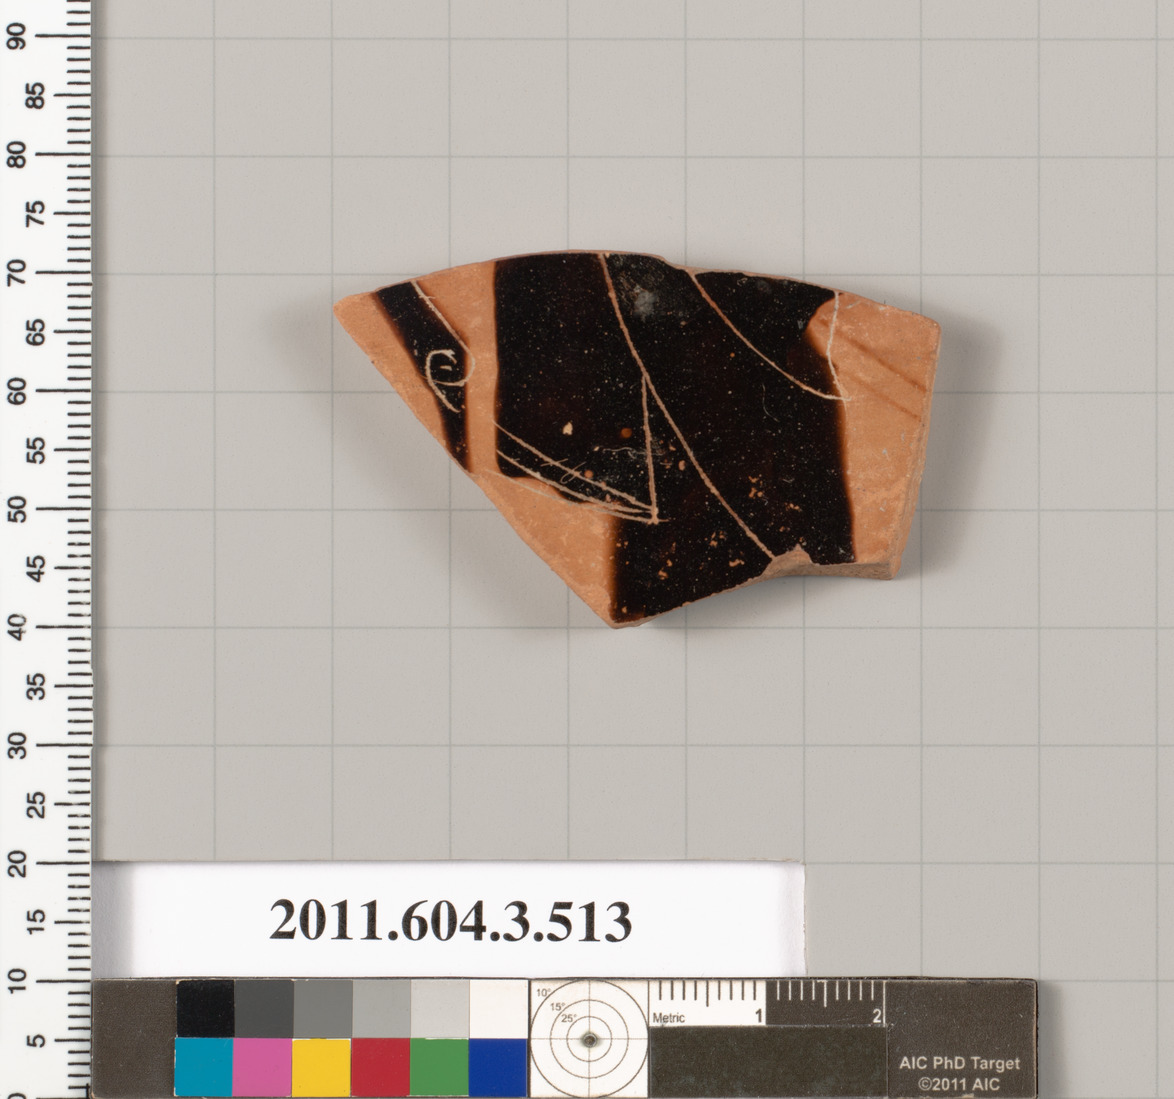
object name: column krater fragment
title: Terracotta fragment of a column-krater (bowl for mixing wine and water)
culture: greek, attic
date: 525-501 BCE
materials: terracotta